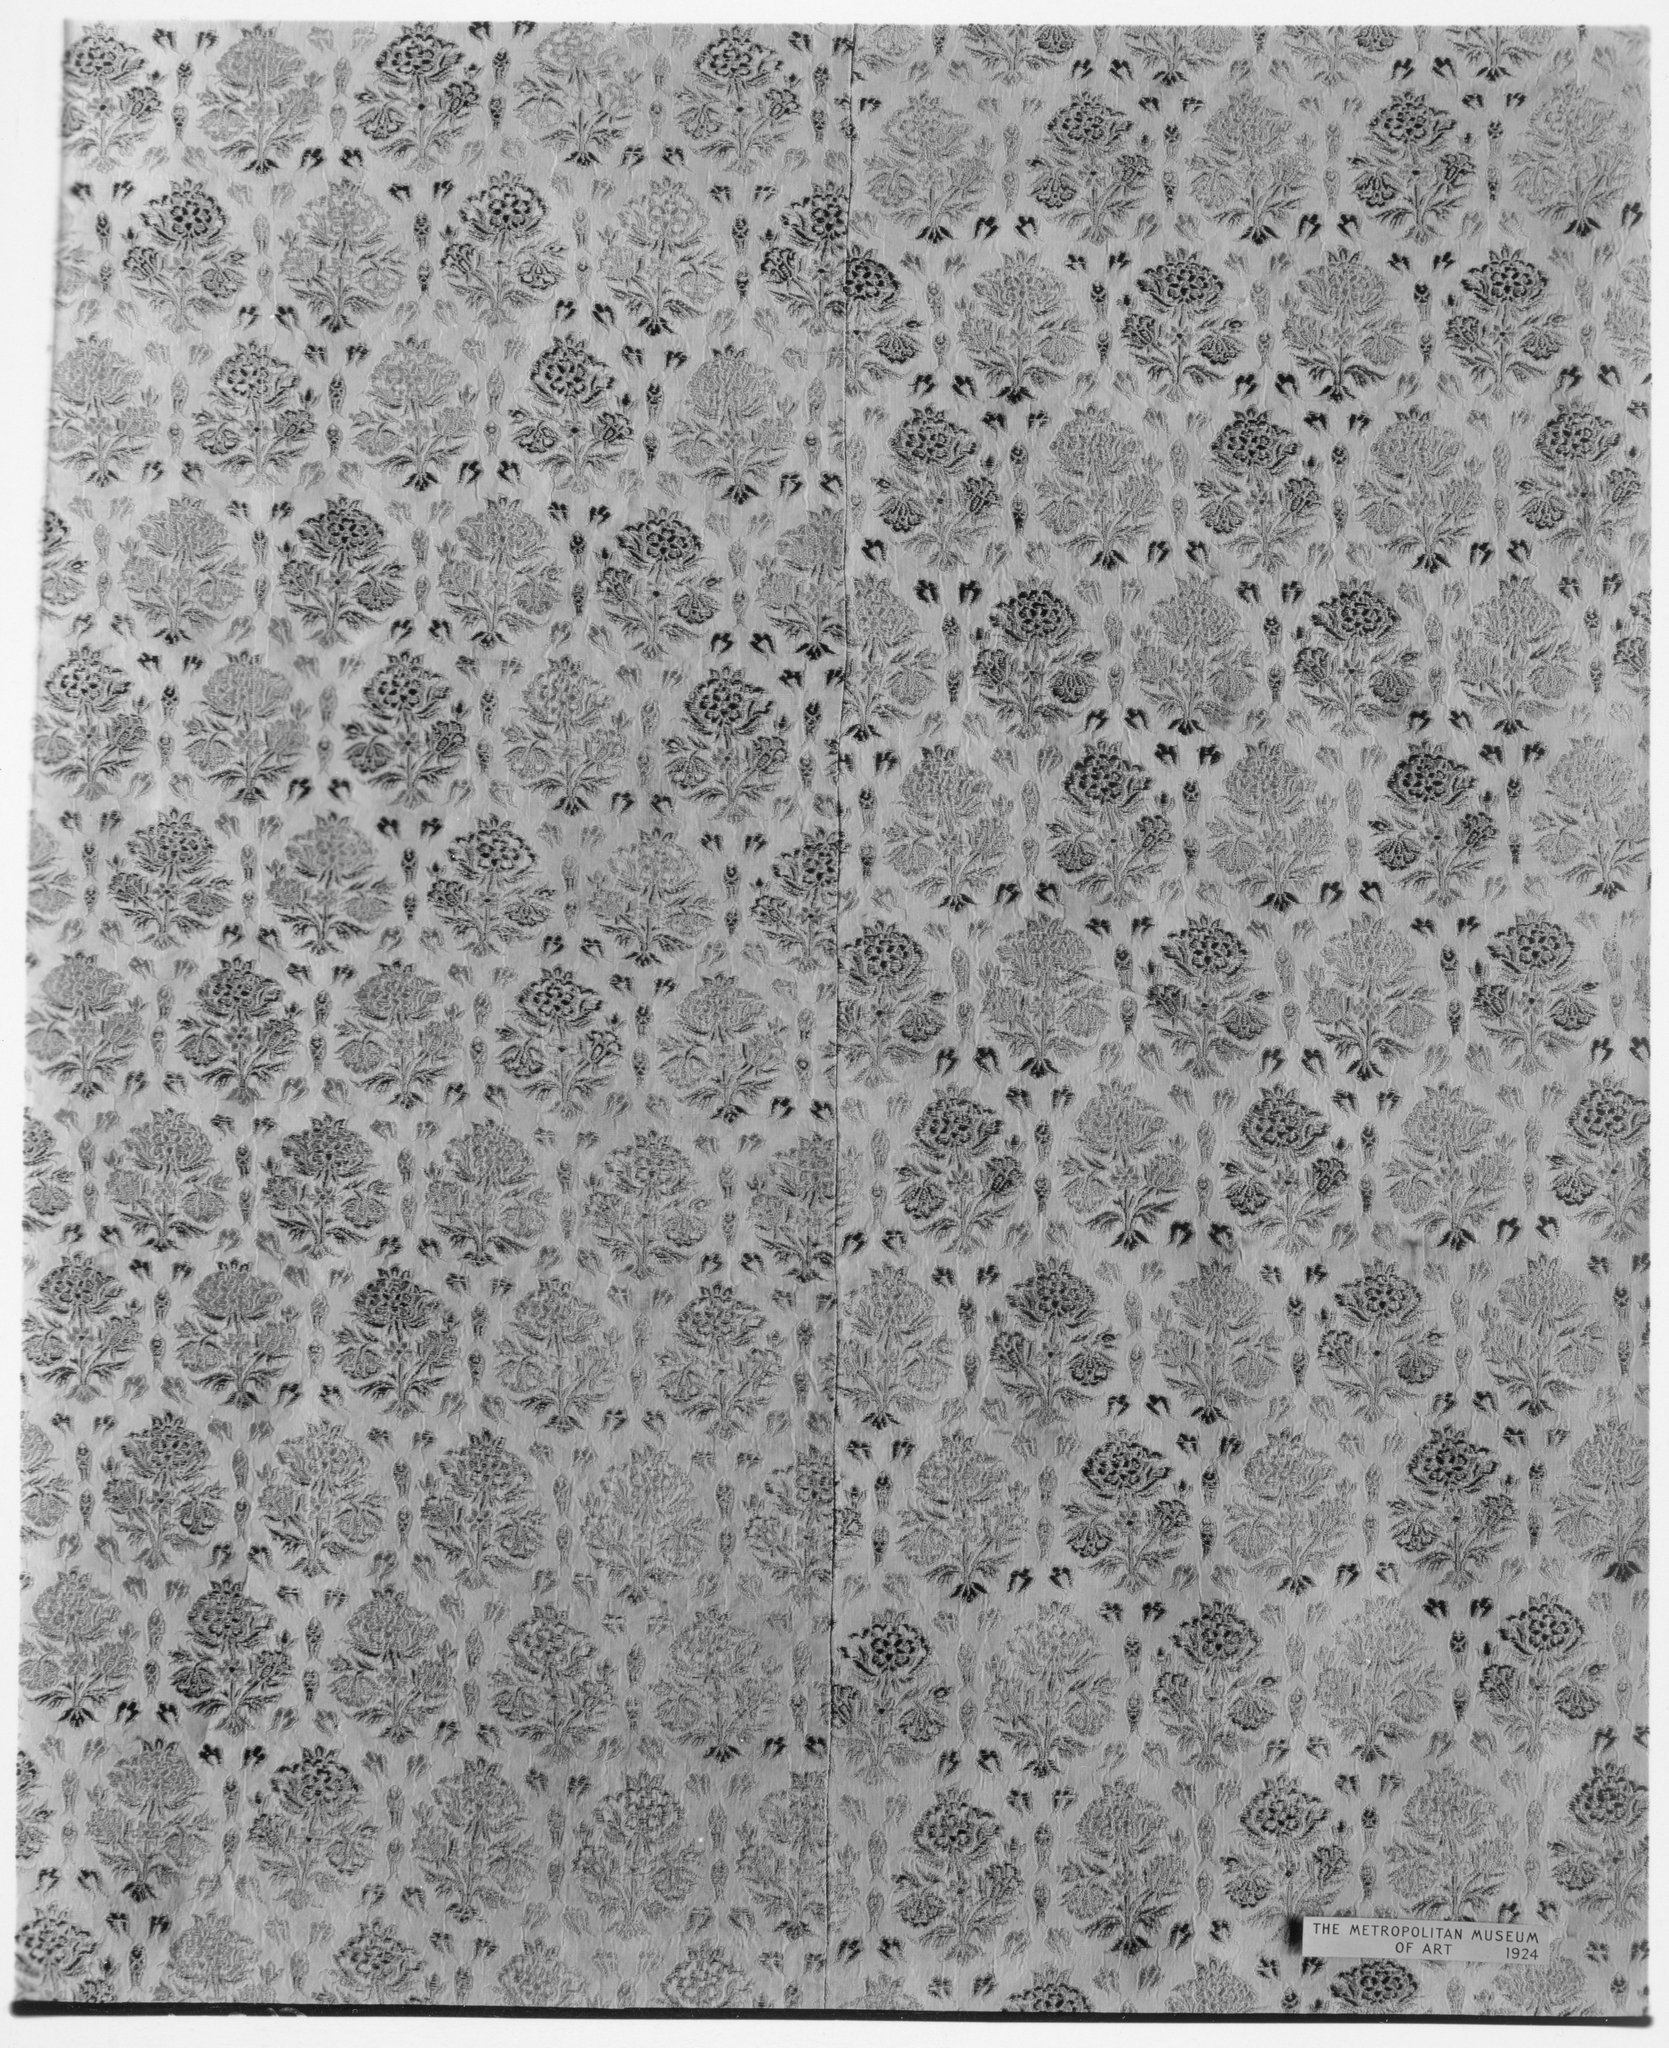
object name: cope fragment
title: Fragment of a Cope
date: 1701-1800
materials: metal thread, silk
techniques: brocade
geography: iran